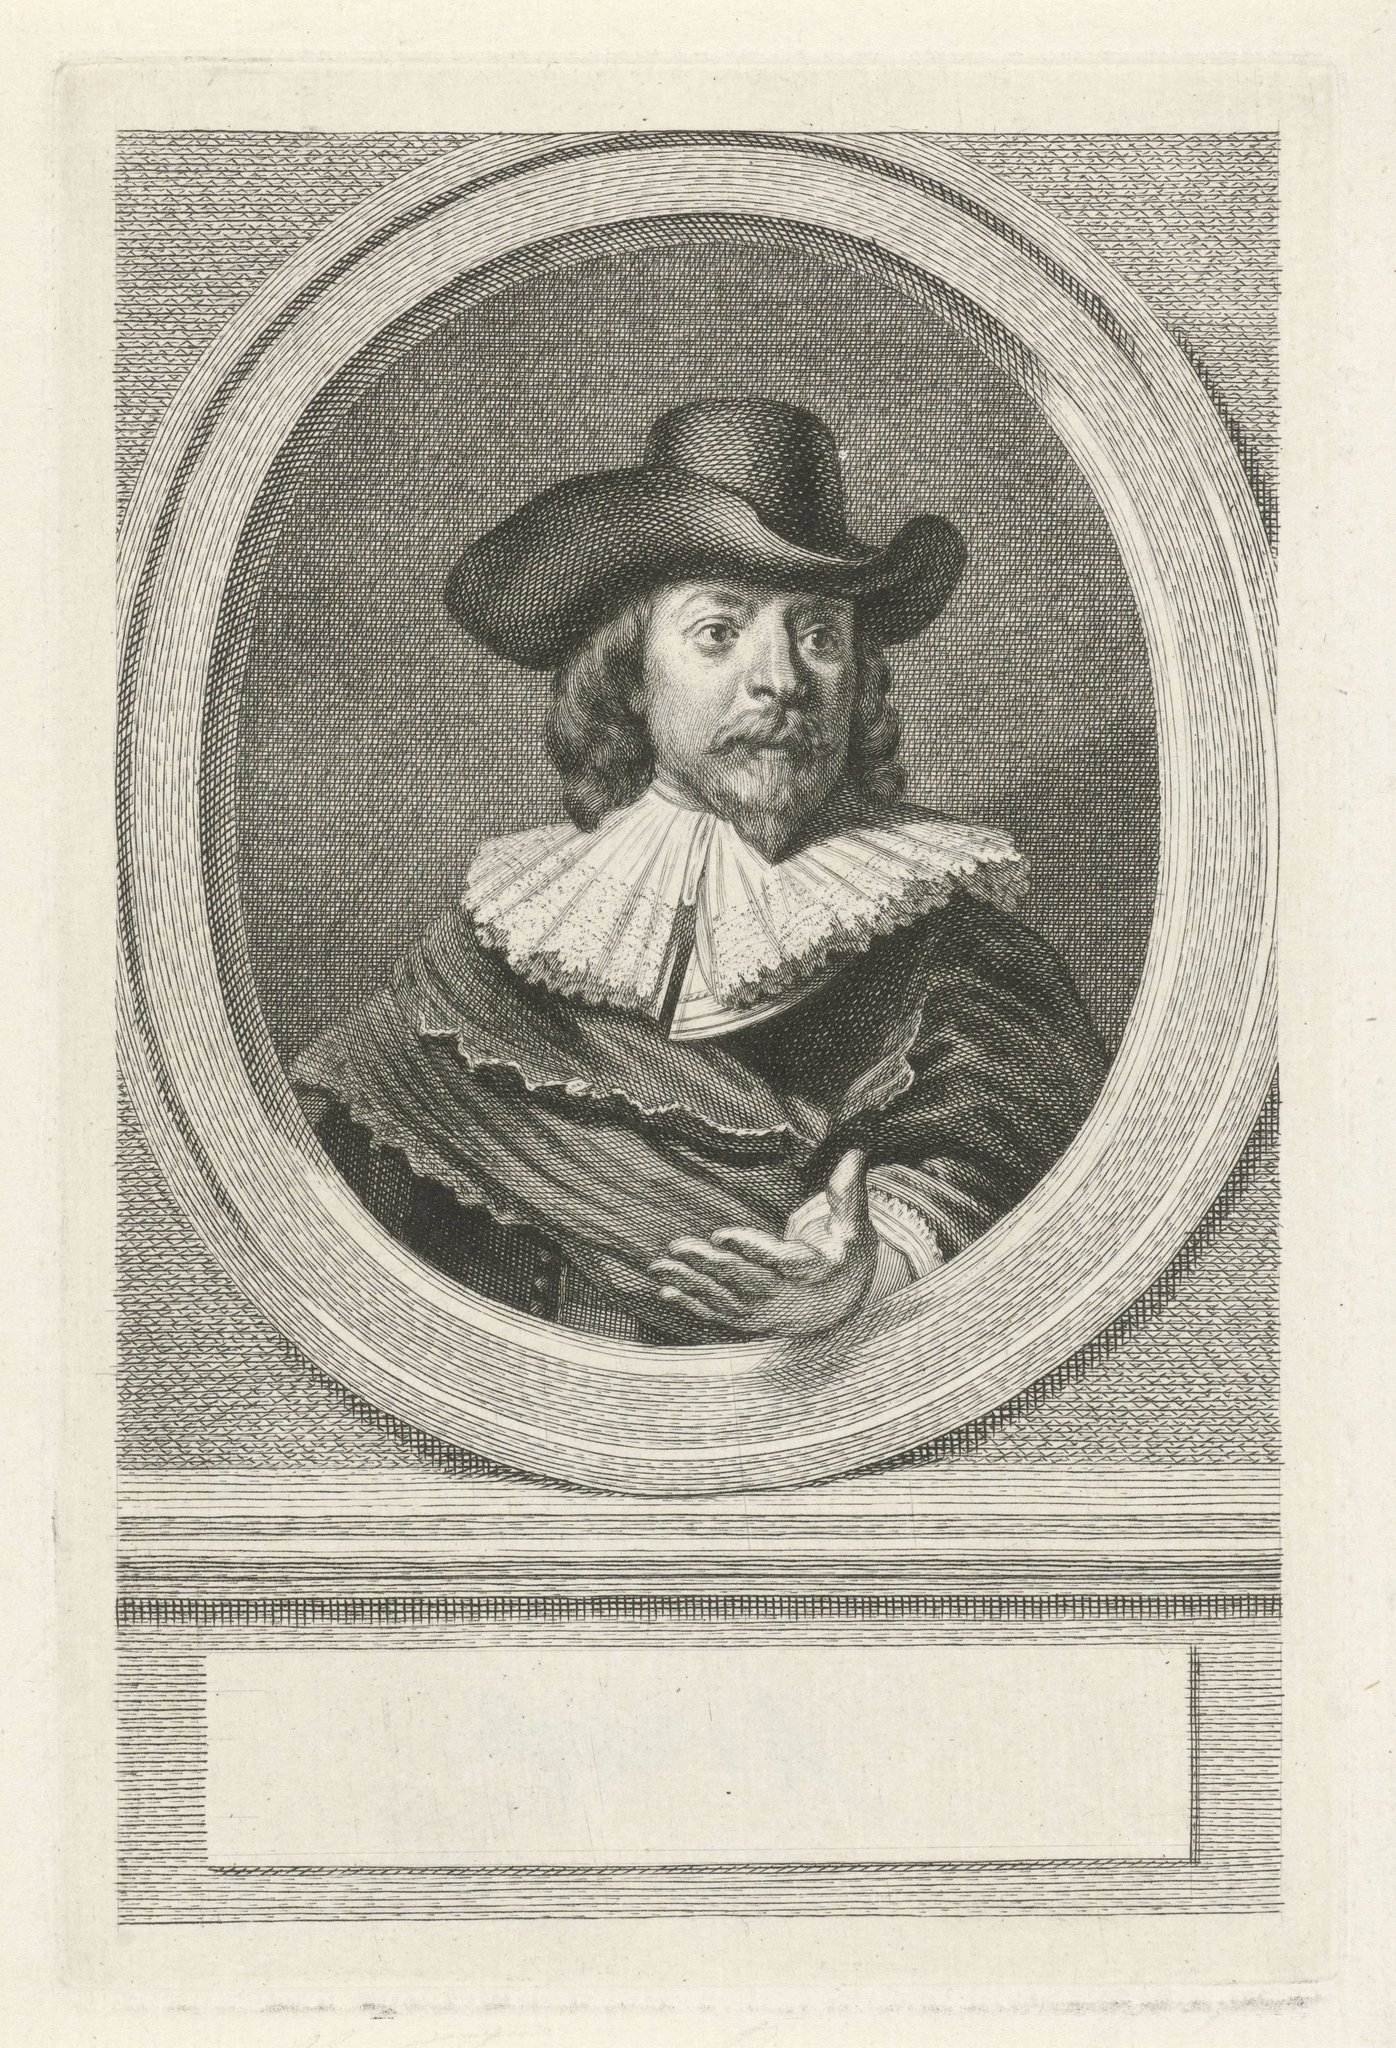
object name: print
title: Portret van Frans Banning Cocq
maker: jacob houbraken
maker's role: draughtsman, print maker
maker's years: 1698-1780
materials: paper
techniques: engraving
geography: amsterdam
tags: mayor, frans banninck cocq, maps of cities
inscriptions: collector's mark: Lugt 2228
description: Prent is gemaakt naar een detail van het schilderij door Rembrandt Harmensz. van Rijn, Officieren en andere schutters van wijk II in Amsterdam onder leiding van kapitein Frans Banninck Cocq en luitenant Willem van Ruytenburch, bekend als de ‘Nachtwacht’, 1642. Collectie Rijksmuseum, Amsterdam, objectnummer SK-C-5. Latere staat van deze prent is oorspronkelijk bedoeld als aanvulling op Jan Wagenaars ‘Vaderlandsche historie’* en was zo vanaf 1796 verkrijgbaar bij Johannes Allart te Amsterdam. Voor de advertentie waarin Allart de 60 portretten en 7 platen, allen gegraveerd door Houbraken, ter aanvulling op Wagenaars ‘Vaderlandsche historie’ aanbiedt, zie RP-P-OB-77.766. *Van dit werk zijn in de achttiende eeuw meerdere uitgaves verschenen, zoals: Wagenaar, Jan. Vaderlandsche historie, vervattende de geschiedenissen der Vereenigde Nederlanden (…). 21 delen. Amsterdam: Isaak Tirion, 1749-1759. Wagenaar, Jan. Vaderlandsche historie, vervattende de geschiedenissen der nu Vereenigde Nederlanden (…). 21 delen. Amsterdam: weduwe Isaak Tirion, 1770. Wagenaar, Jan. Vaderlandsche historie, vervattende de geschiedenissen der nu Vereenigde Nederlanden (…). 21 delen. Amsterdam, Leiden, Dordrecht en Harlingen: P. Schouten e.a., 1782. Wagenaar, Jan. Vaderlandsche historie, vervattende de geschiedenissen der nu Vereenigde Nederlanden (…). 21 delen. Amsterdam: Johannes Allart, 1790-1796.